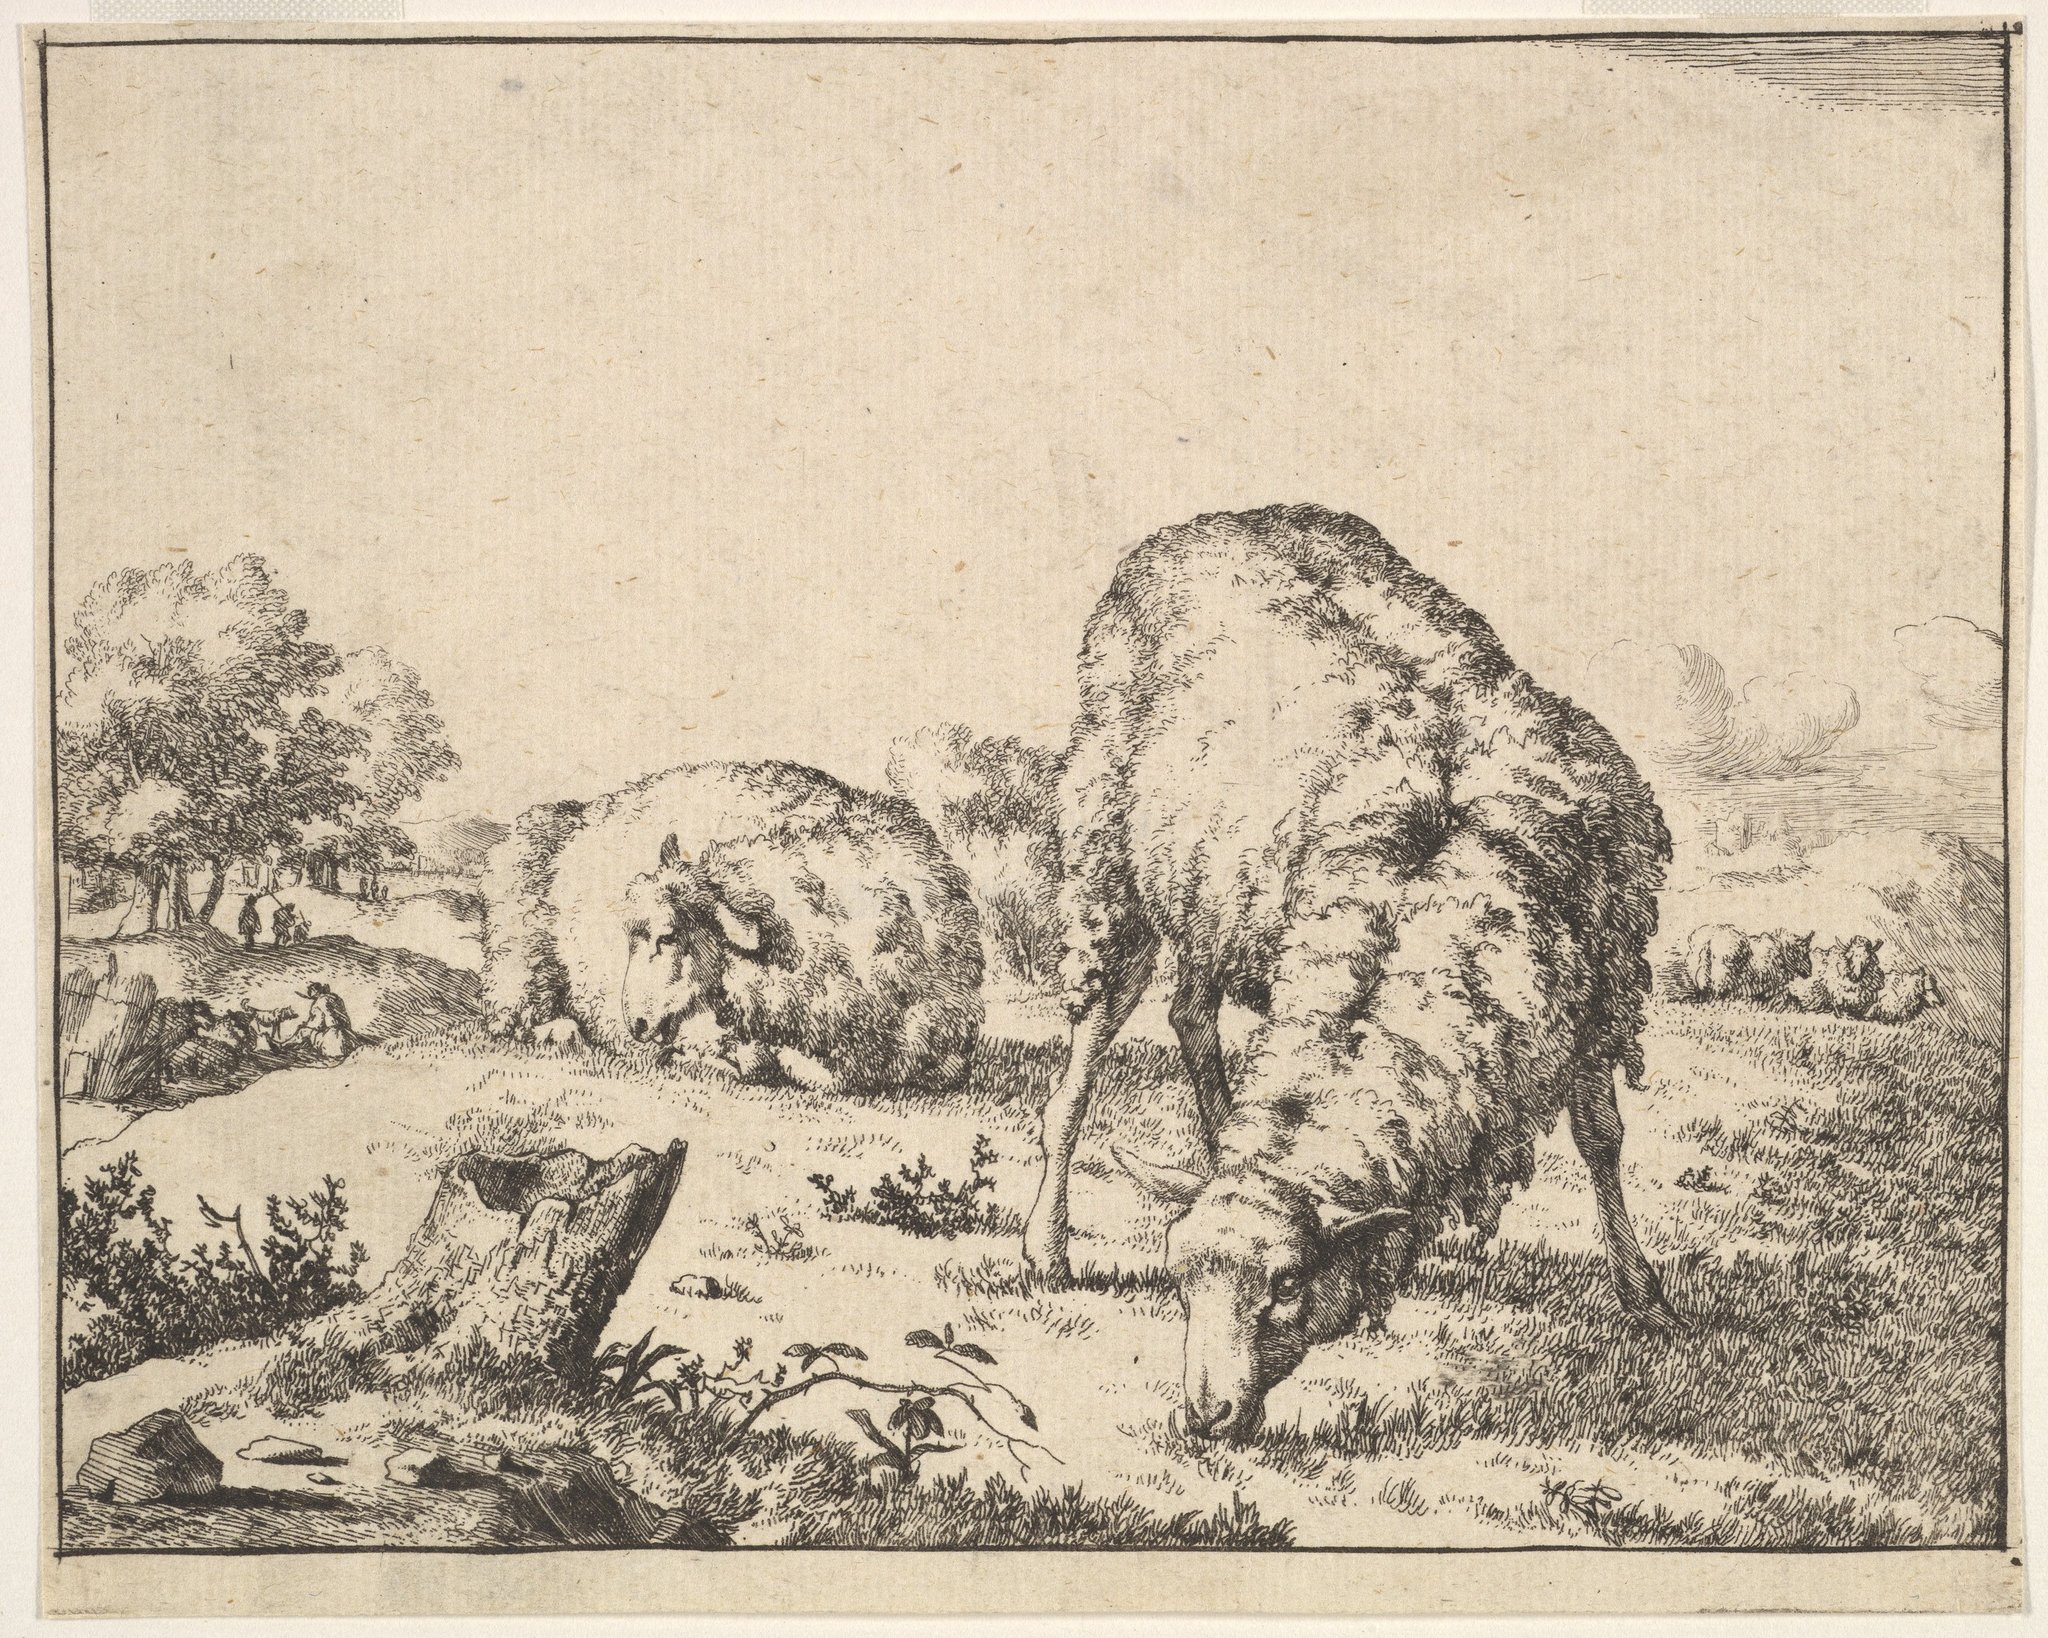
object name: print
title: Sheep, from a set of 16 plates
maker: marcus de bye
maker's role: artist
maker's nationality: dutch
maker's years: 1639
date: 1664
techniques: etching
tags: sheep